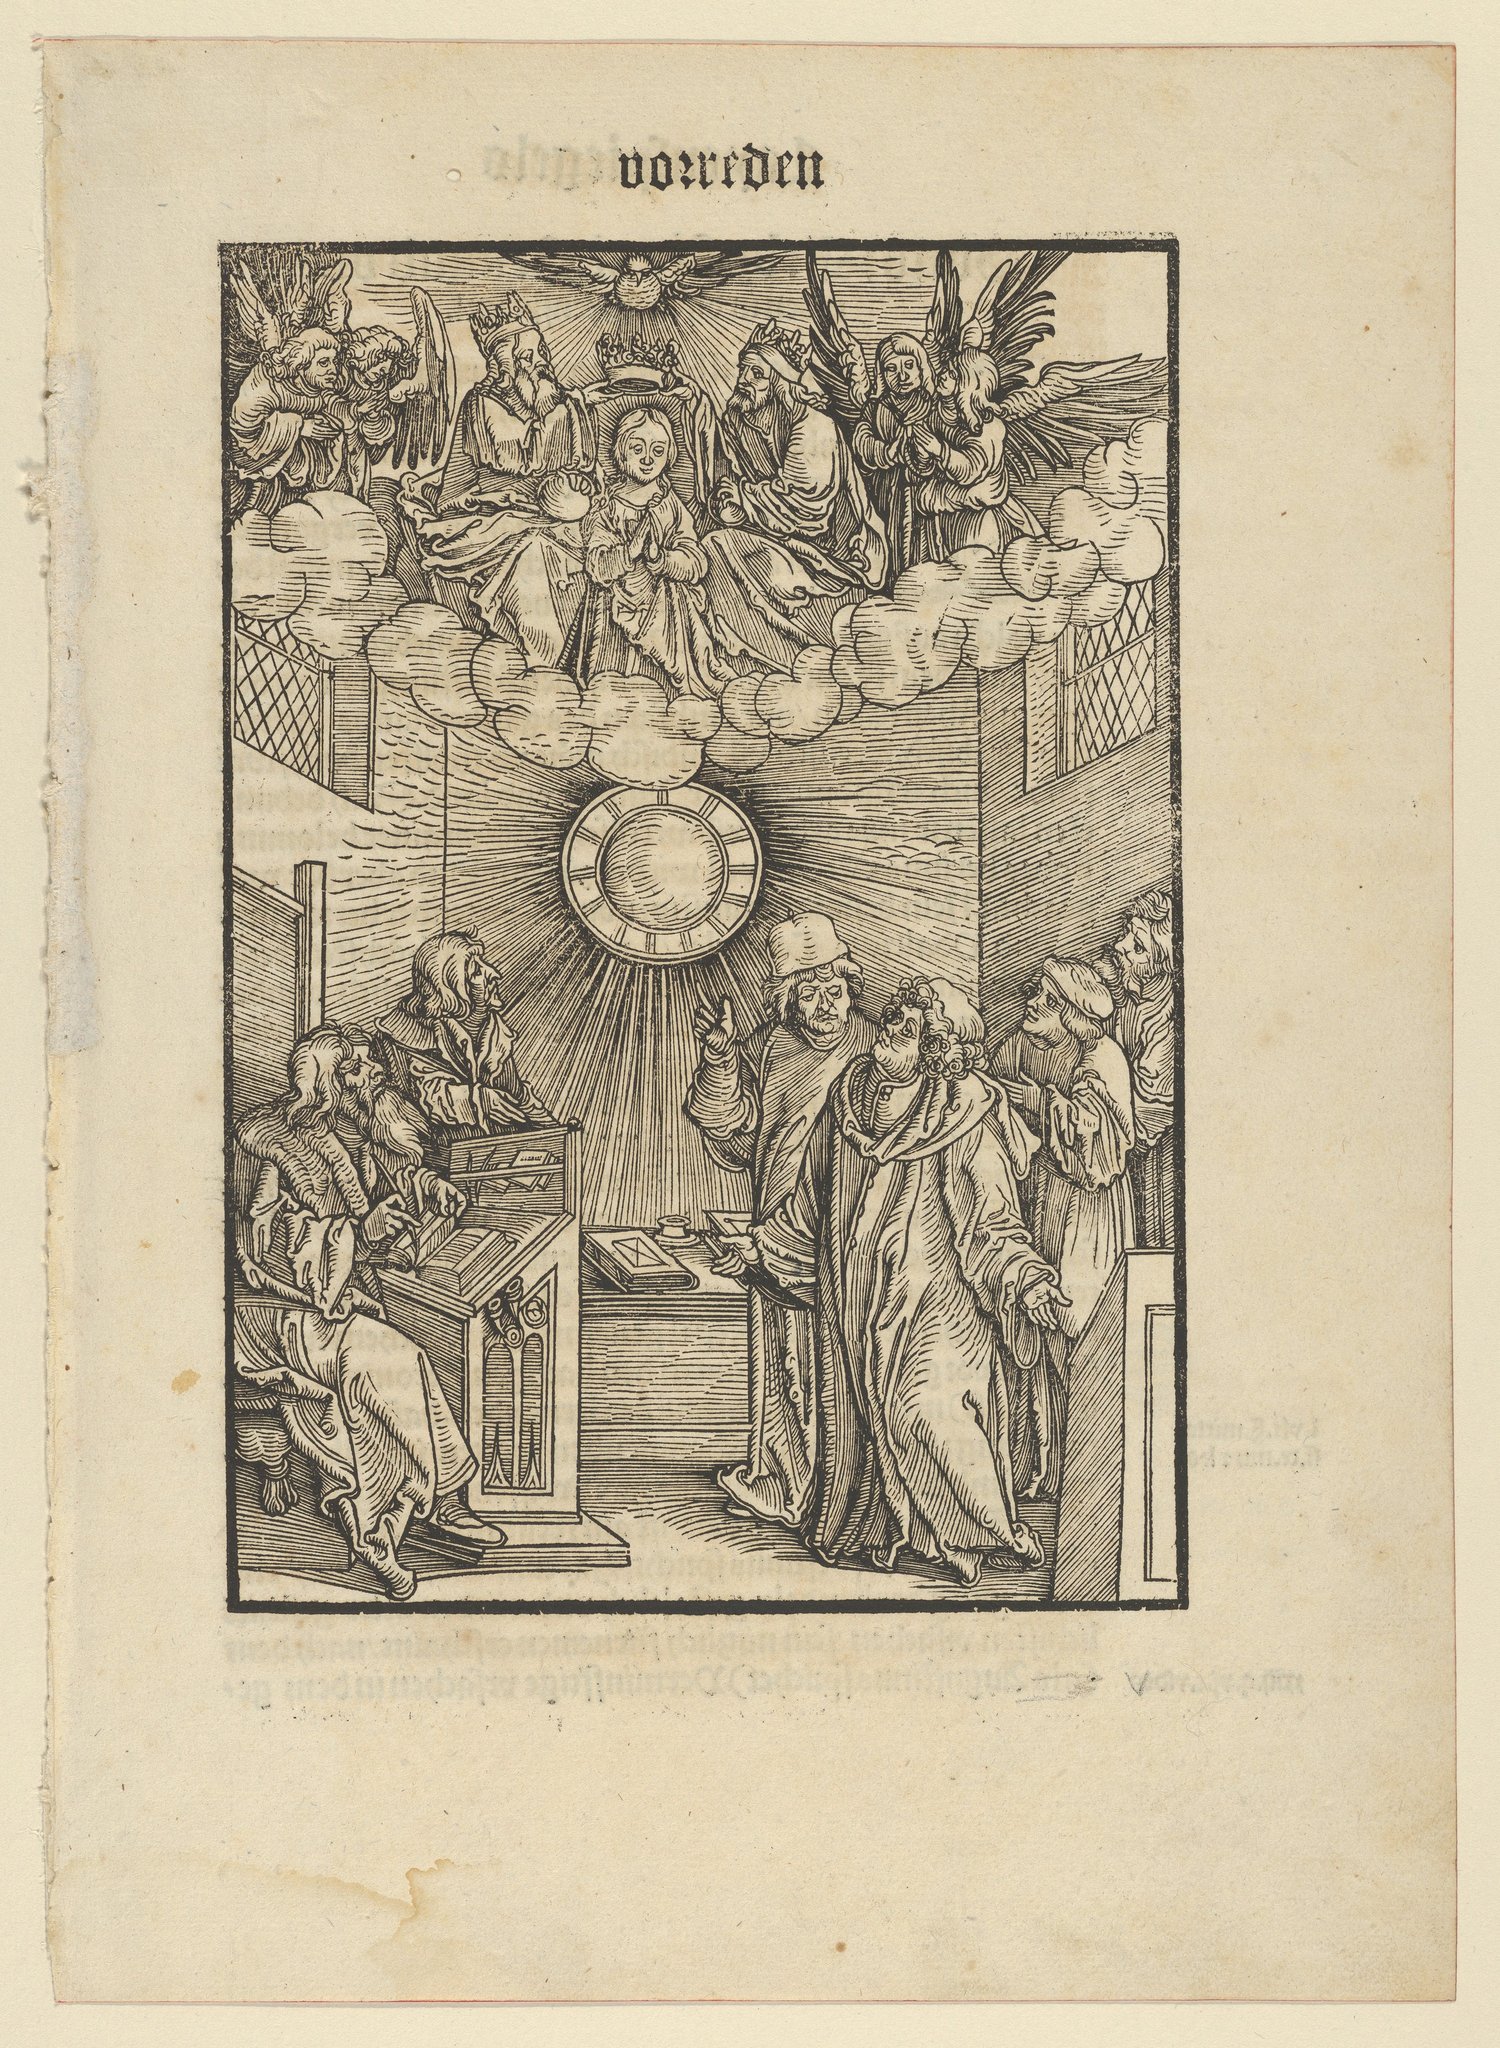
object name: print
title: The Author Writing the Layenspiegel; The Trinity and the Virgin at the Upper Center, from "Der Neue Layenspiegel"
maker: hans schäufelein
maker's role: artist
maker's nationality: german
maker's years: 1480-1540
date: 1511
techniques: woodcut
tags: men,angels,virgin mary